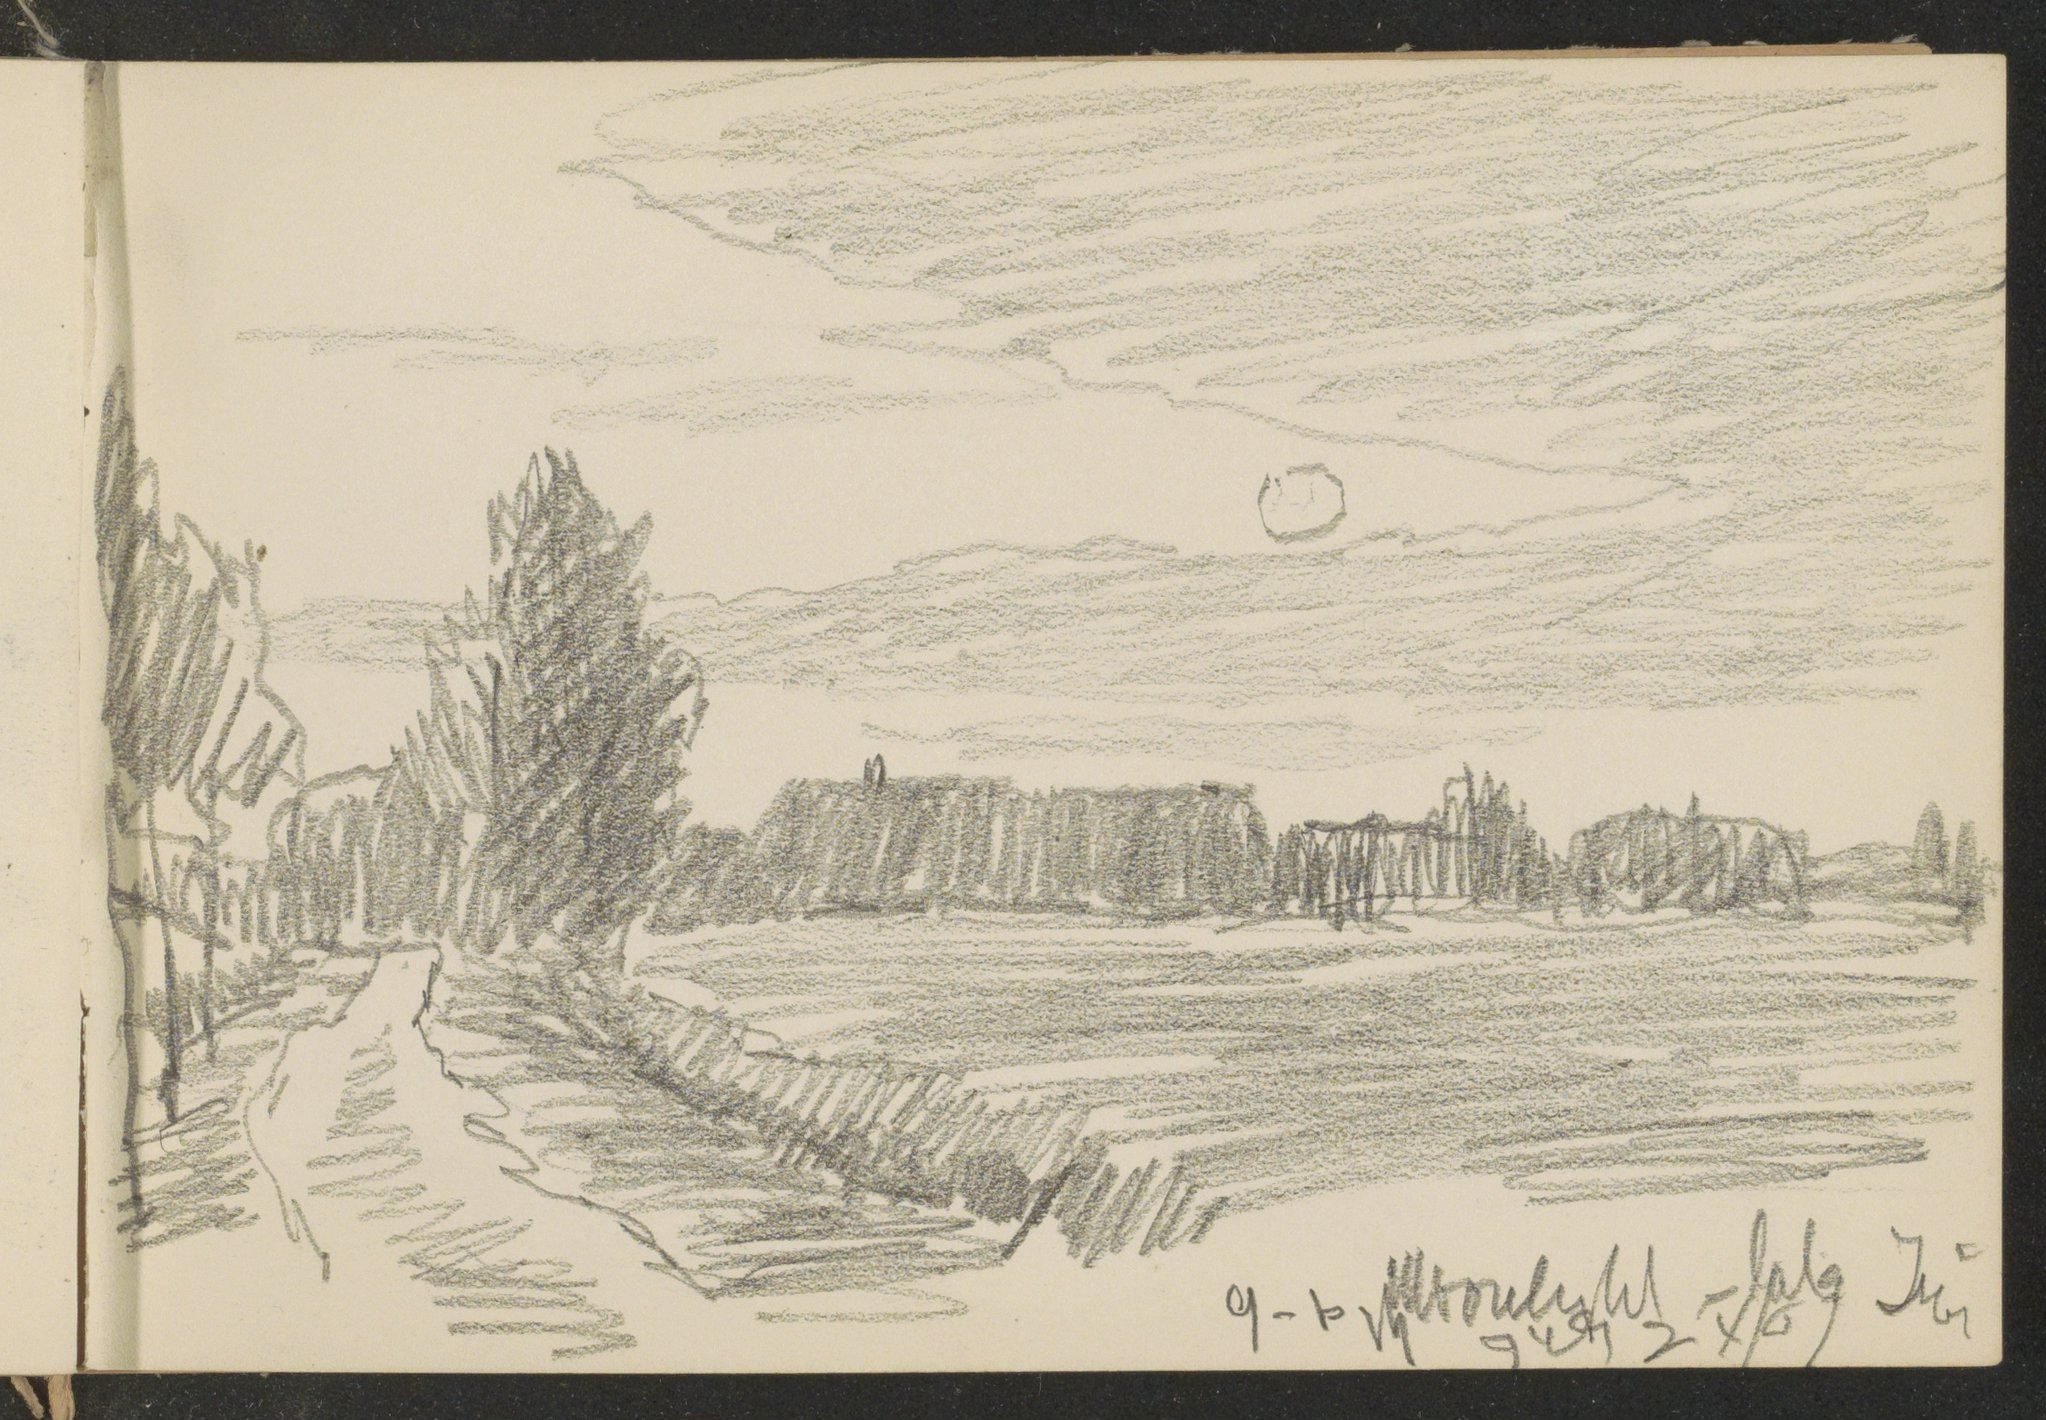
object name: sketchbook leaf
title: Pad en boerderij in een landschap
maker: alexander shilling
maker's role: draughtsman, print maker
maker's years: 1859-1937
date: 1907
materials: paper, pencil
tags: fence, wall, paling, farm (building)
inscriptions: date and inscription: ‘9-b Mooulyk[...]? - [...]alf Ju[...]/Jul 24/07’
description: Blad 24 recto uit een schetsboek met 24 bladen.